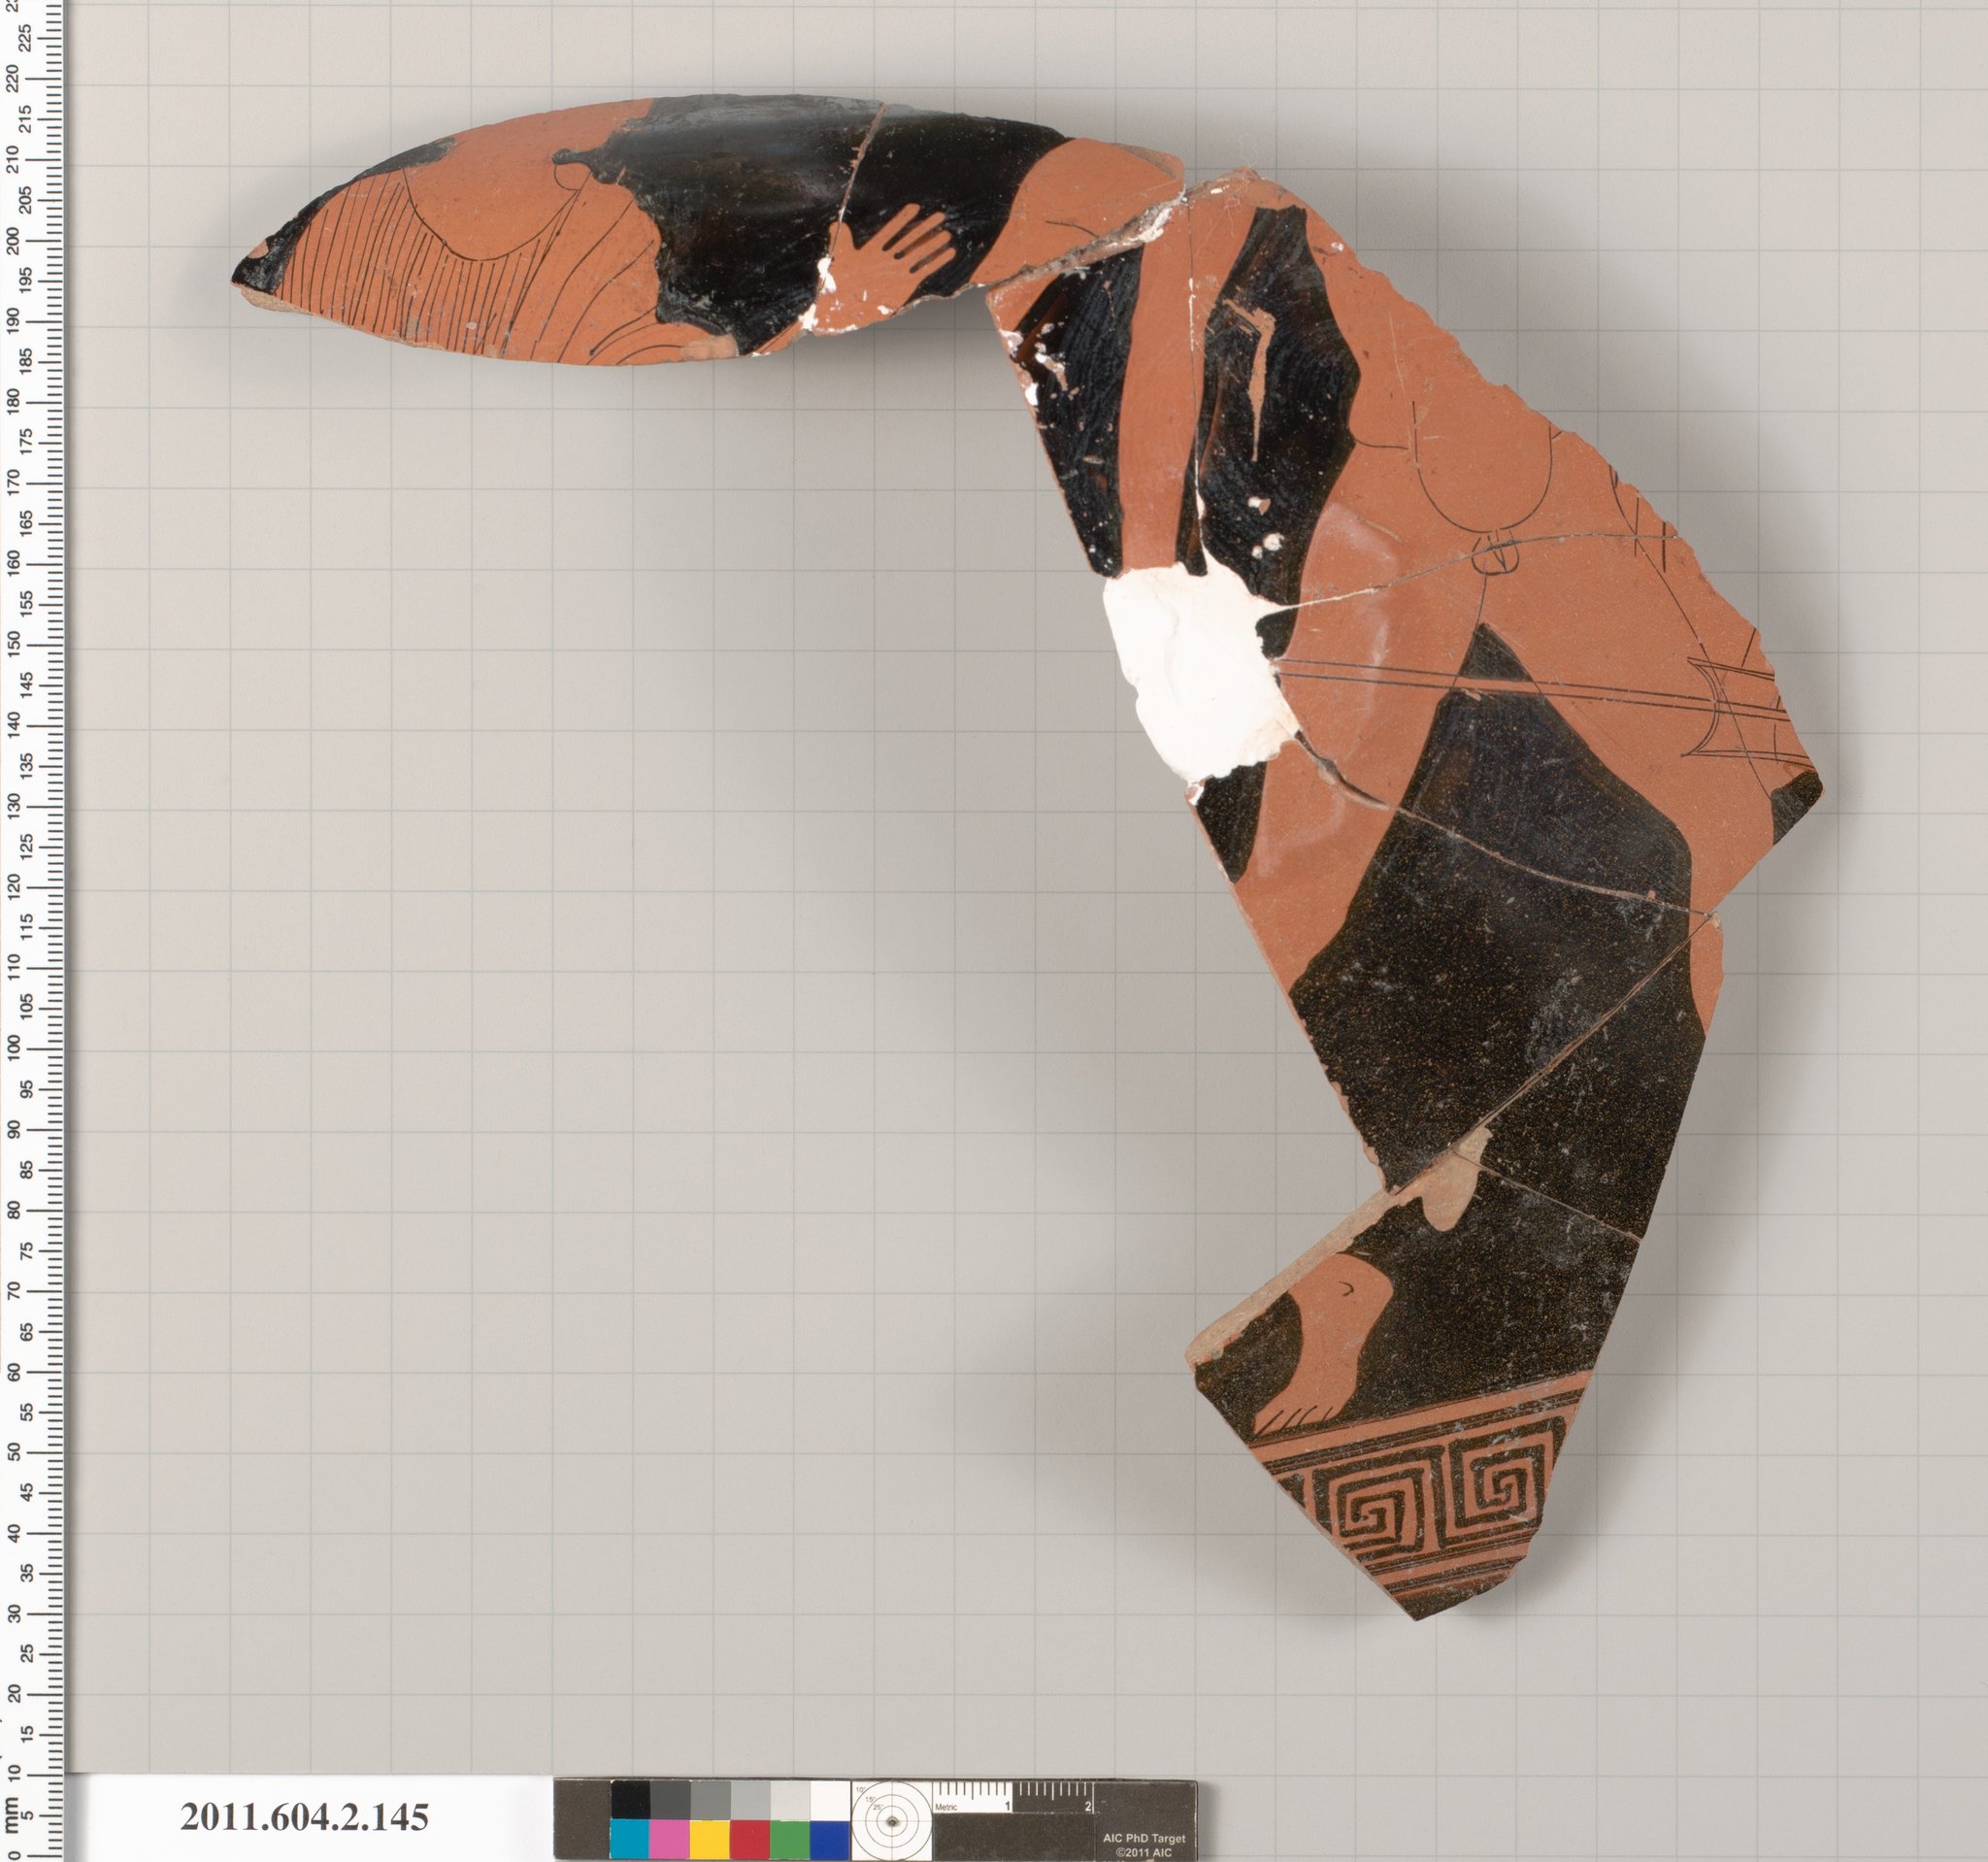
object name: stamnos fragment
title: Terracotta fragment of a stamnos (jar)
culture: greek, attic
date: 470-460 BCE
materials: terracotta